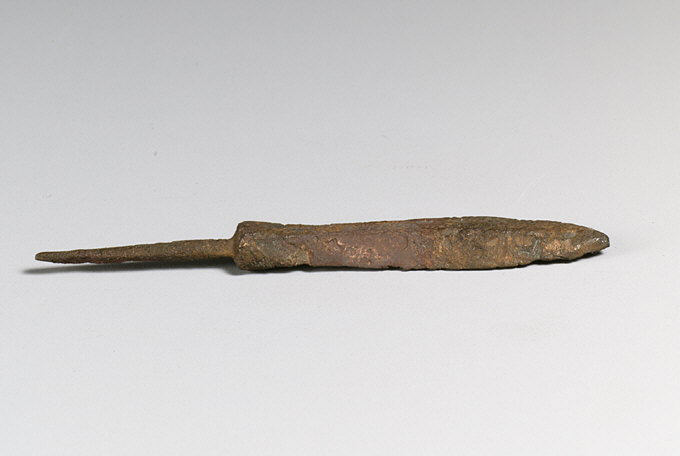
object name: arrowhead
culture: greek, cypriot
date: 480-330 BCE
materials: bronze